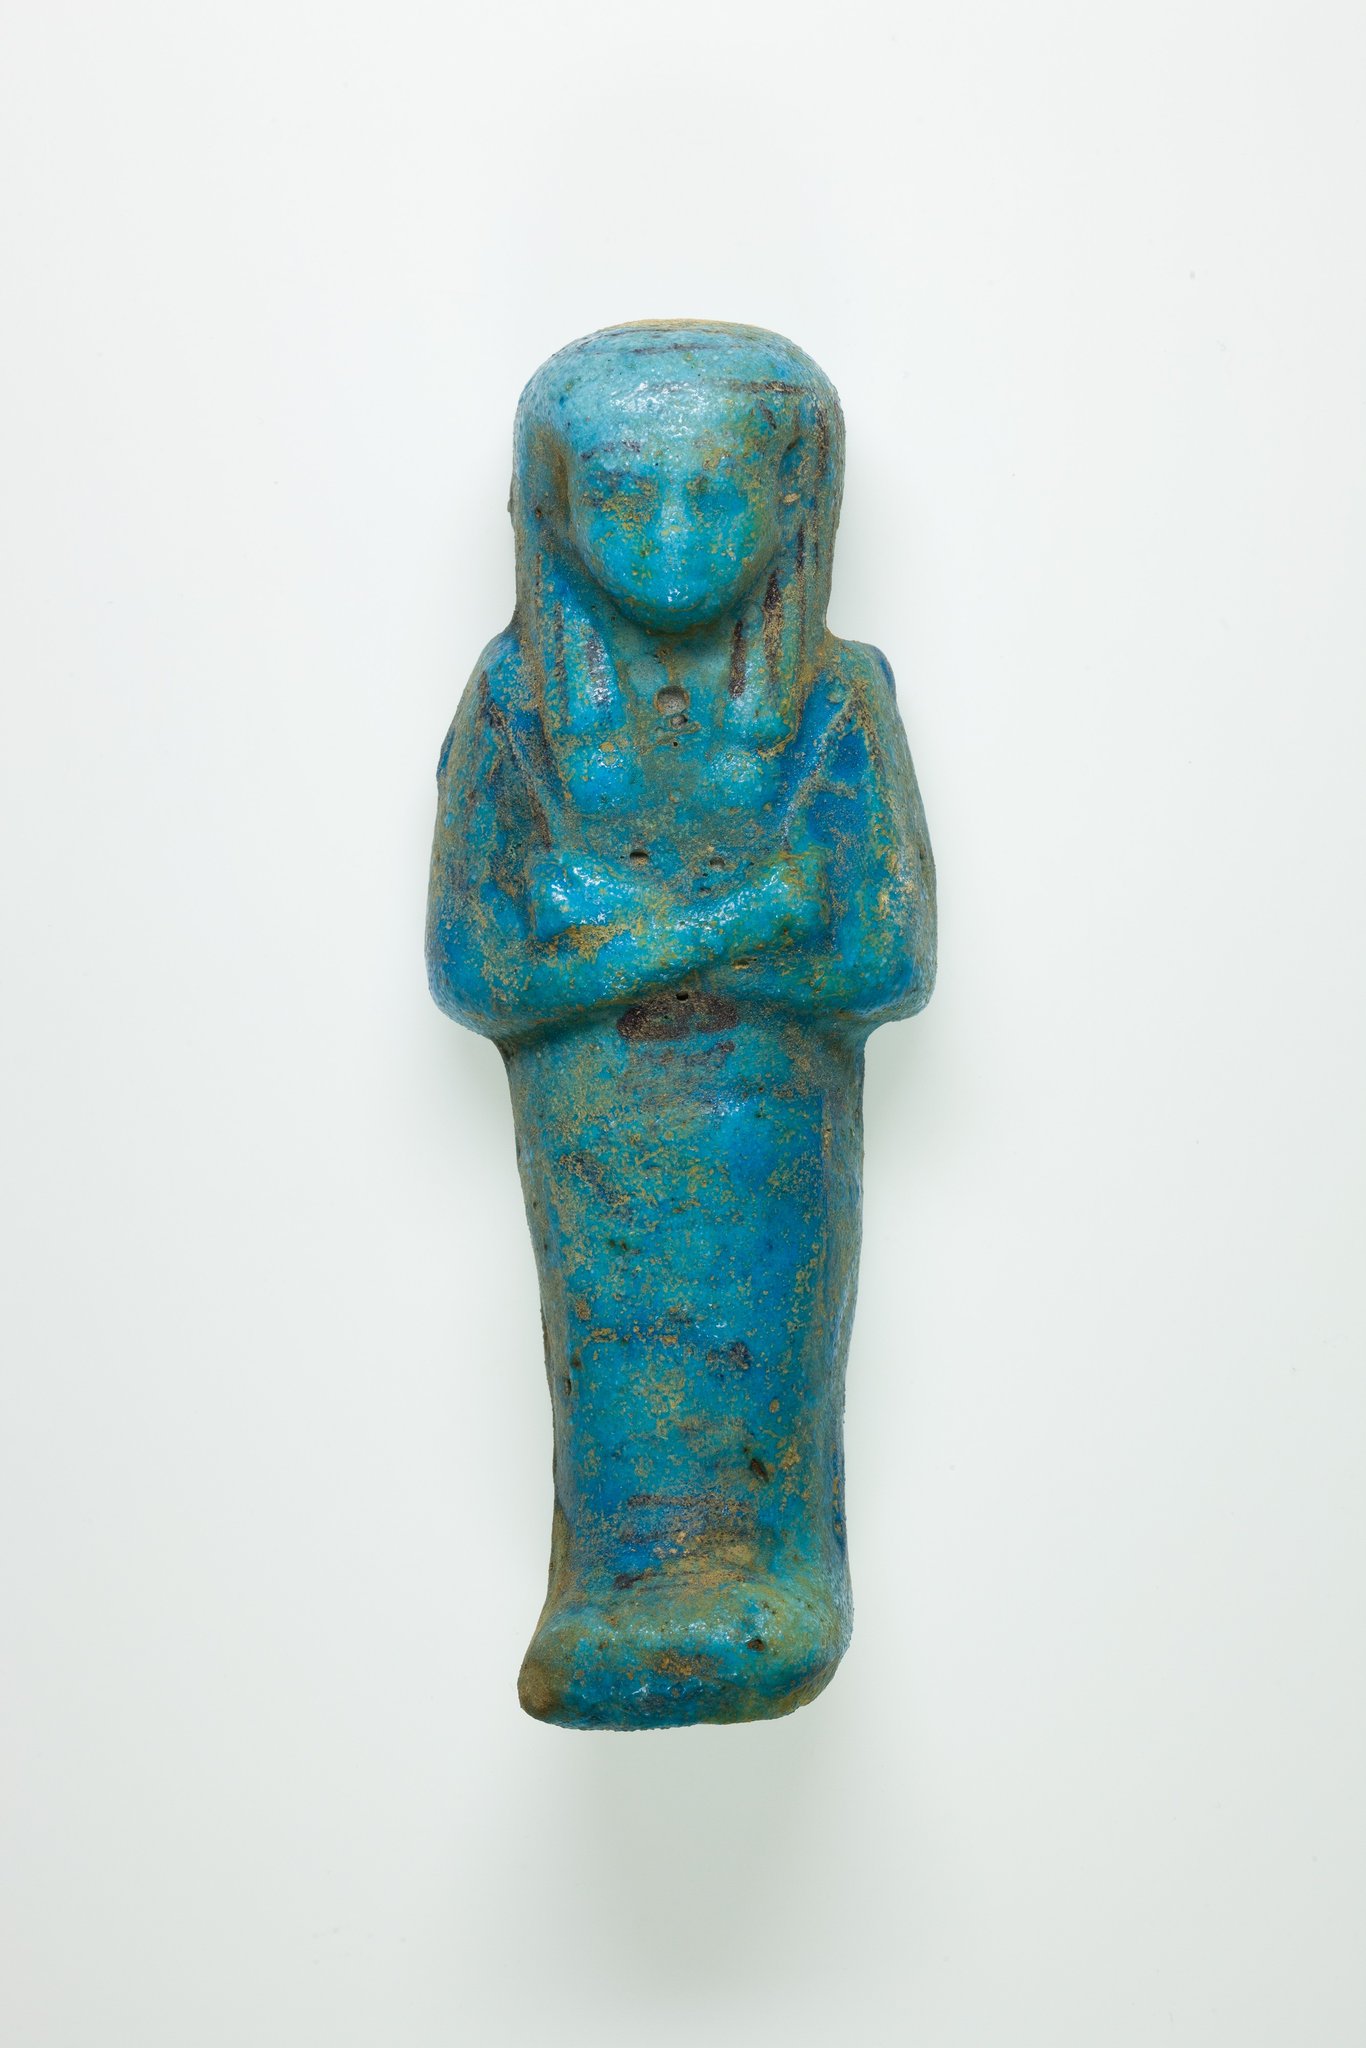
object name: worker shabti, henettawy c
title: Worker Shabti of Henettawy (C), Daughter of Isetemkheb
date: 990-970 BCE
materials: faience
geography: egypt